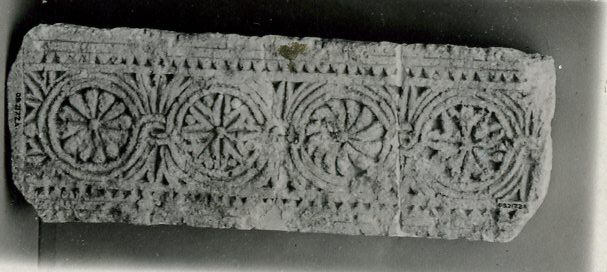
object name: frieze fragment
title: Fragment of a Frieze with Medallions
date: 501-800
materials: limestone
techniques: carving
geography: egypt